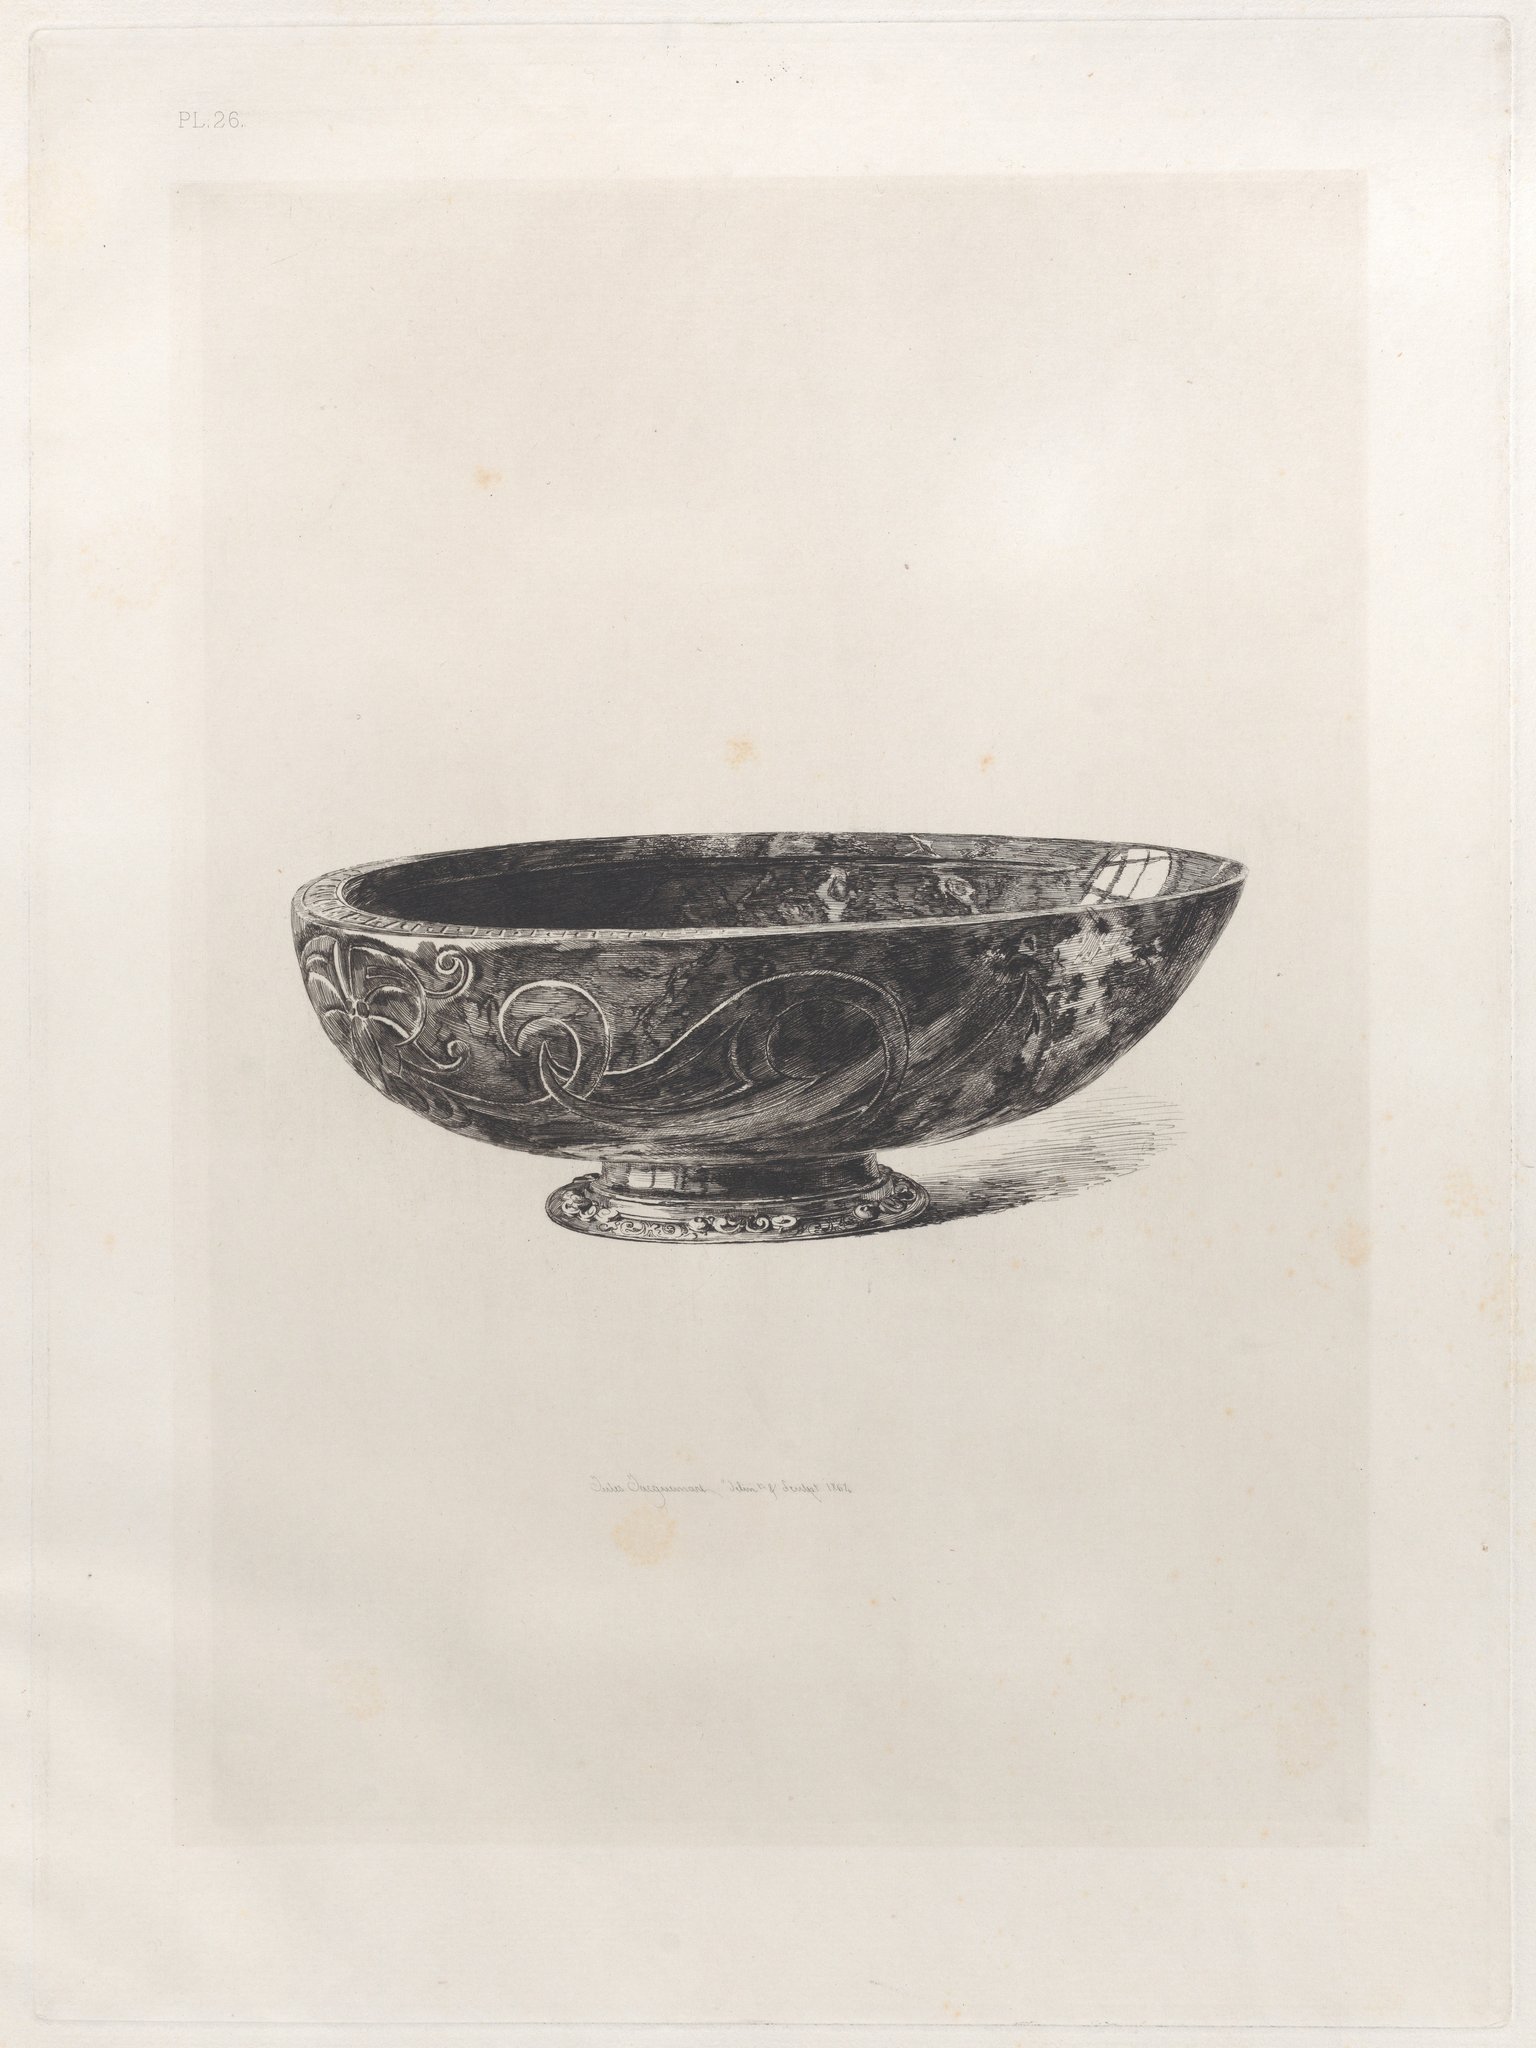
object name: print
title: Oriental Jasper Bezel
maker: jules-ferdinand jacquemart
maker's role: artist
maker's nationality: french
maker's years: 1837-1880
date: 1864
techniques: etching